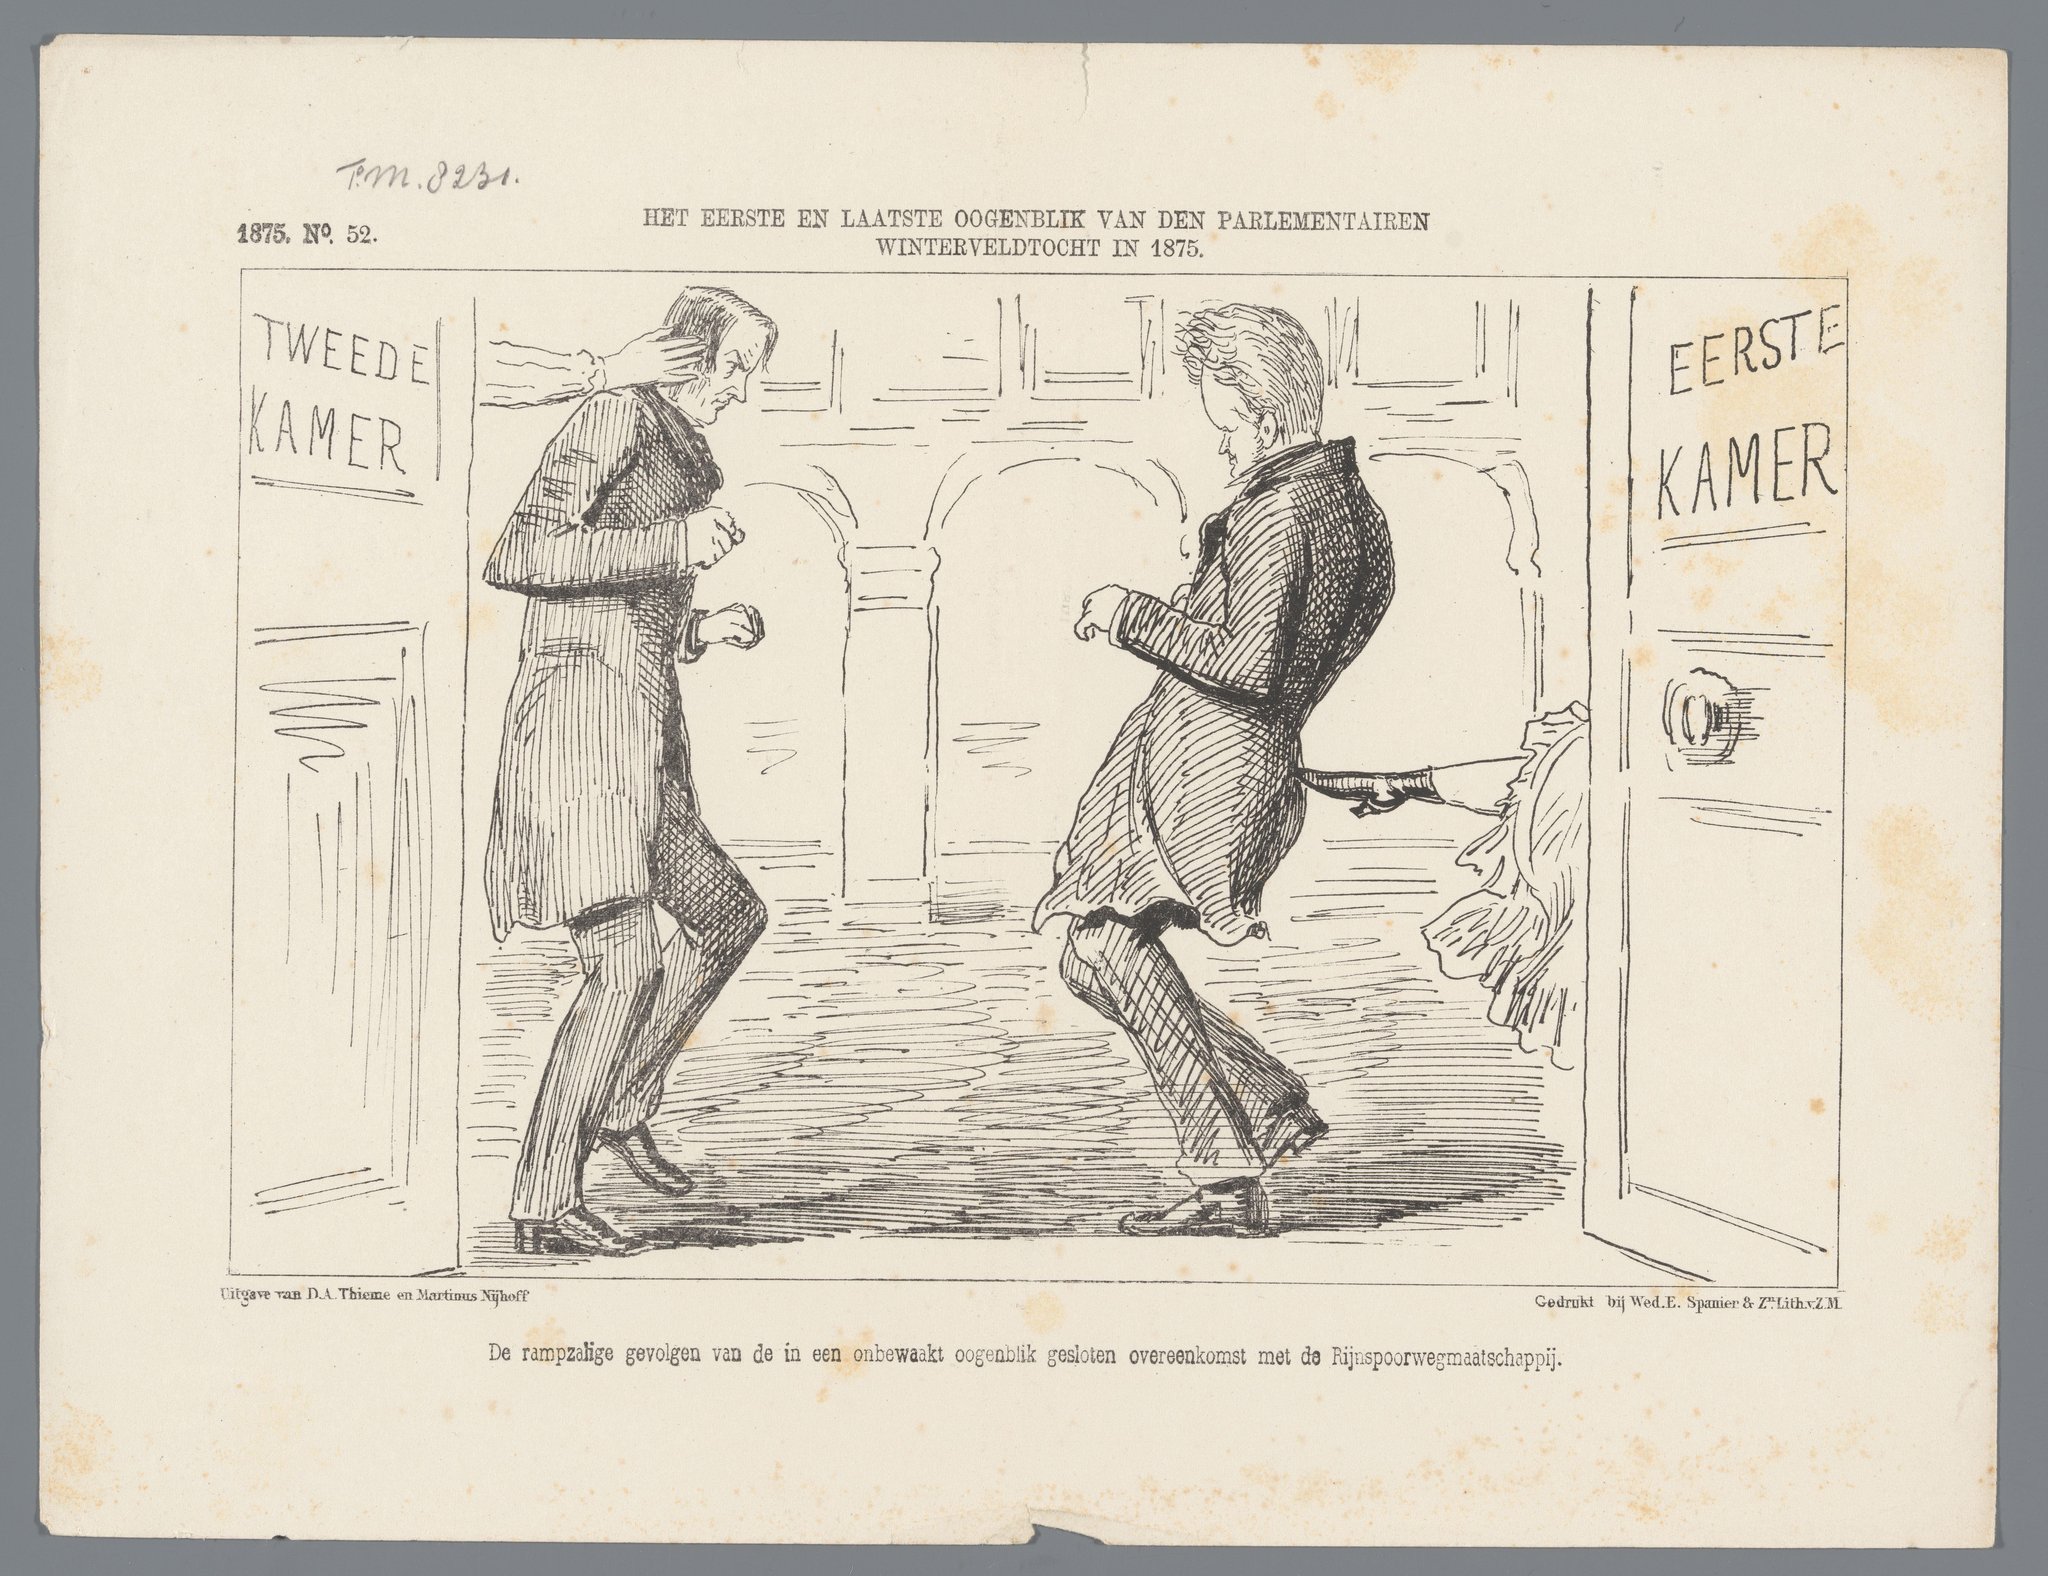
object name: text sheet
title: Schets, verklaring en toelichting der acht tafereelen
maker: pieter wilhelmus van de weijer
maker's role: print maker, printer, publisher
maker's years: 1816-1880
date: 1851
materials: paper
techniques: letterpress printing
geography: utrecht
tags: students' pageant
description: Blad met de gedrukte titel van de verklaring en de handgeschreven titels van de voorstellingen van de acht taferelen. Onderdeel van de serie van acht prenten van de maskerade van de studenten van de Utrechtse Hogeschool voorstellende episodes uit de vaderlandse geschiedenis, 25 juni 1851. Zie ook de verklaring van de voorstelling van de prent, apart gepubliceerd.